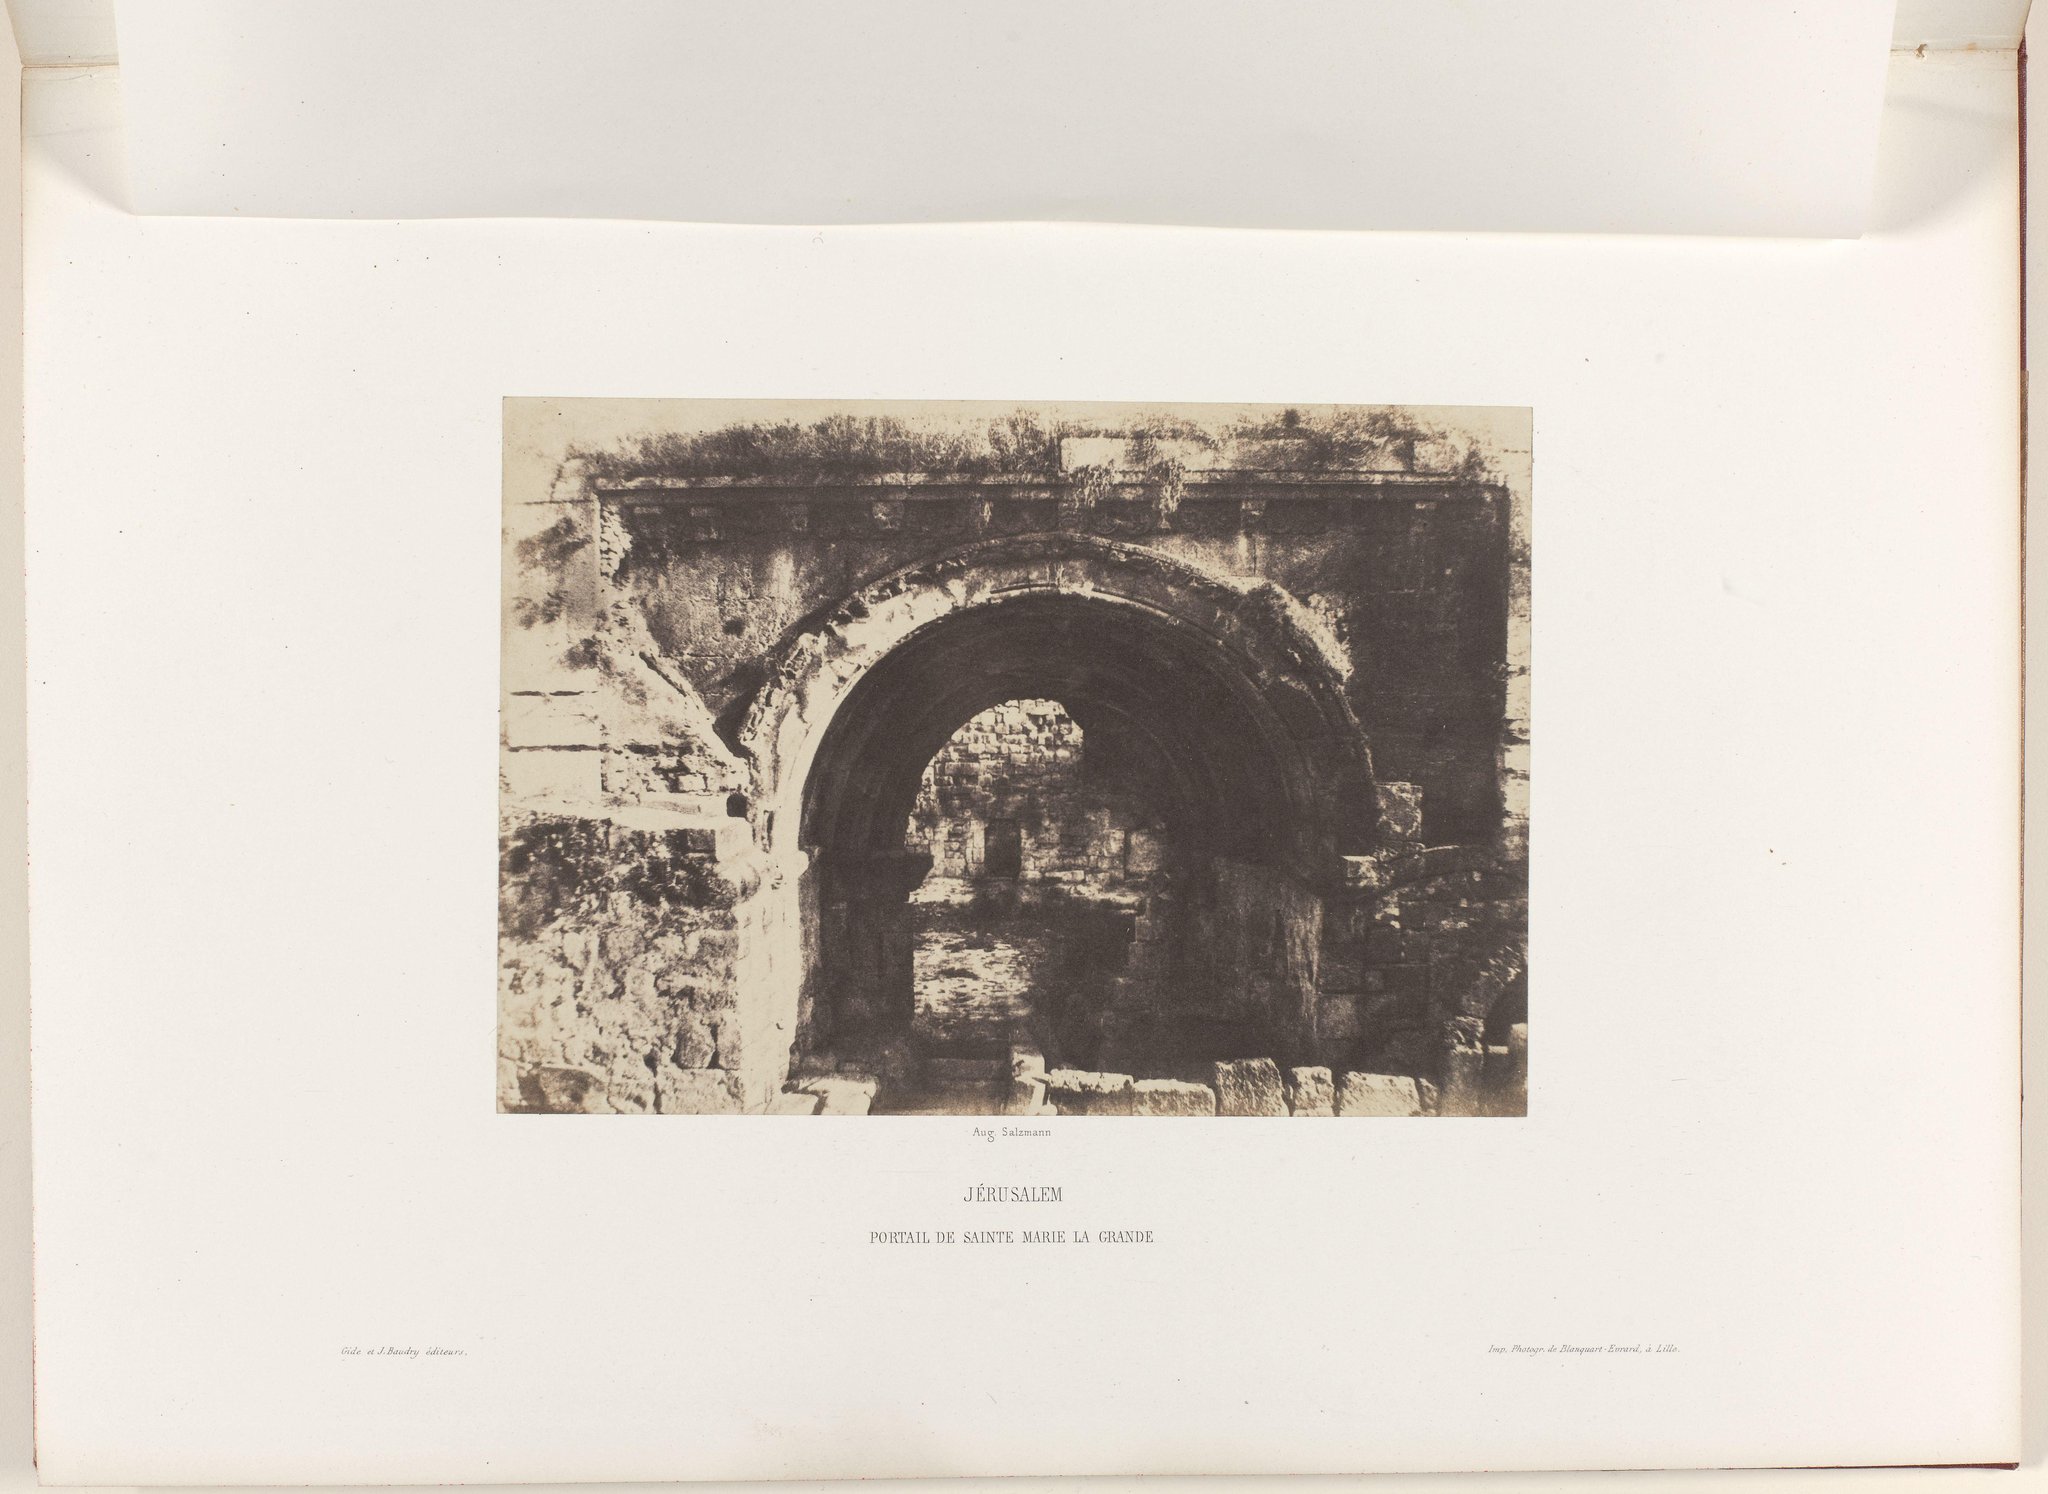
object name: photograph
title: Boog van de kerk Sint-Maria van de Latijnen, Jeruzalem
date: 1854-1856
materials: cardboard, paper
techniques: salted paper print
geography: paris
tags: arch, archivolt ~ architecture, church (exterior)